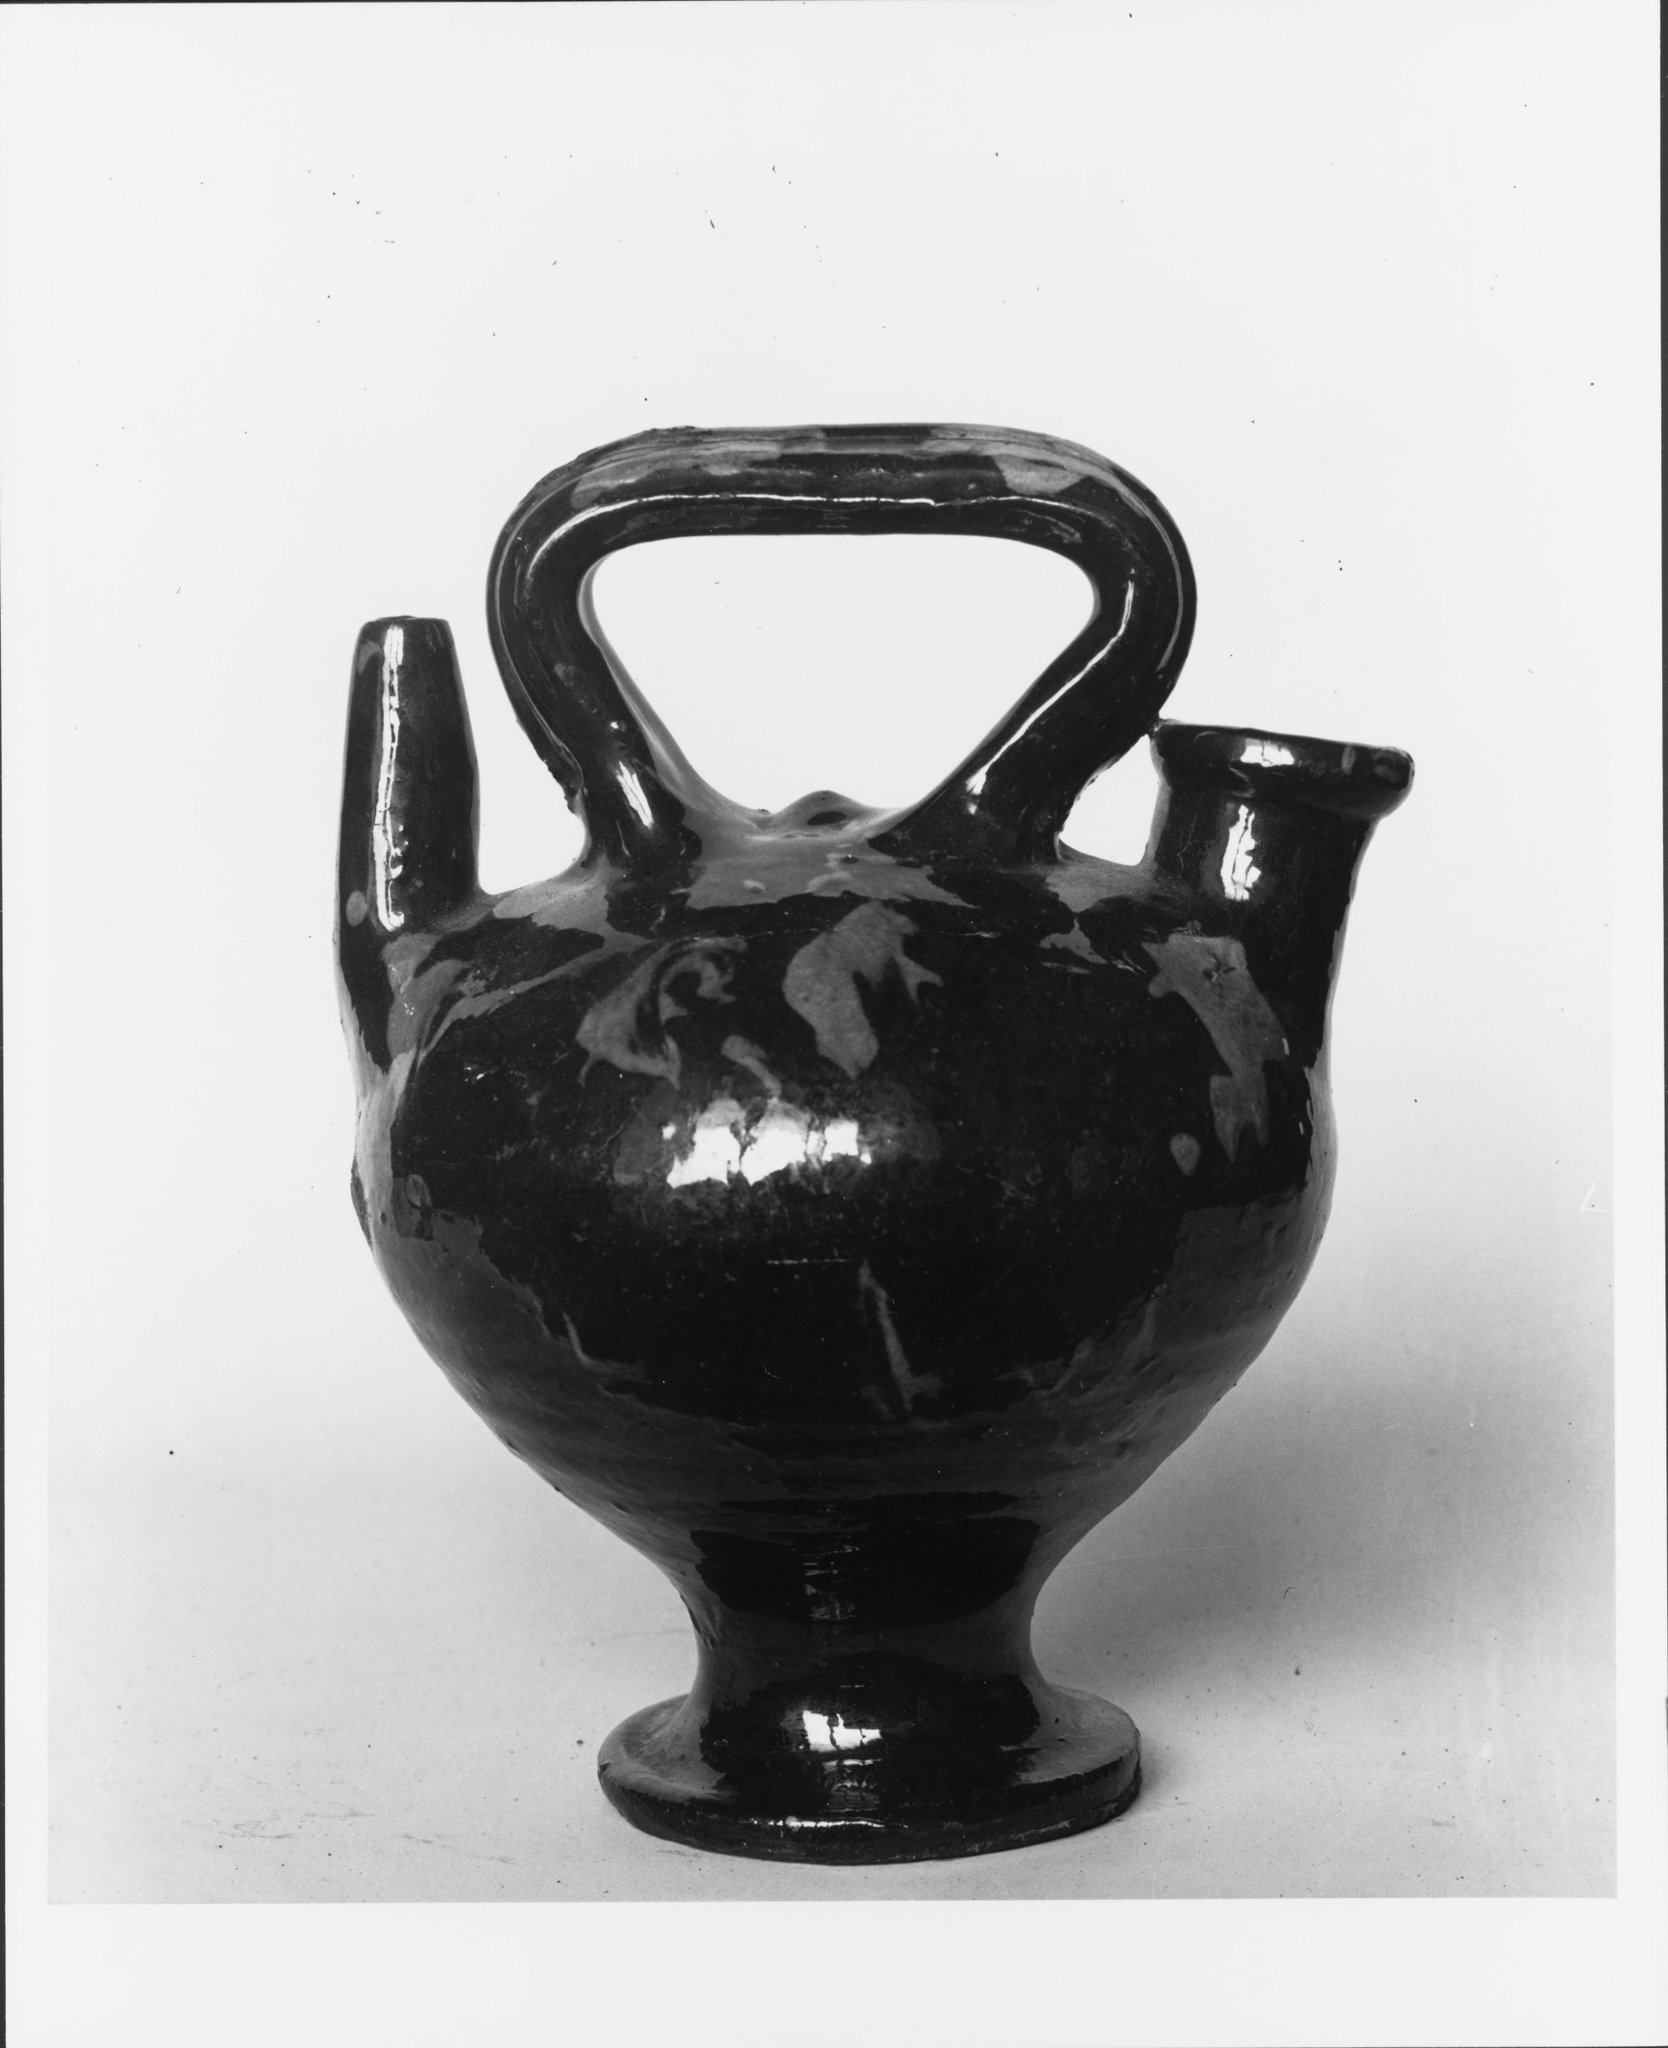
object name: oil cruet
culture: european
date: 1800-1900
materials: earthenware